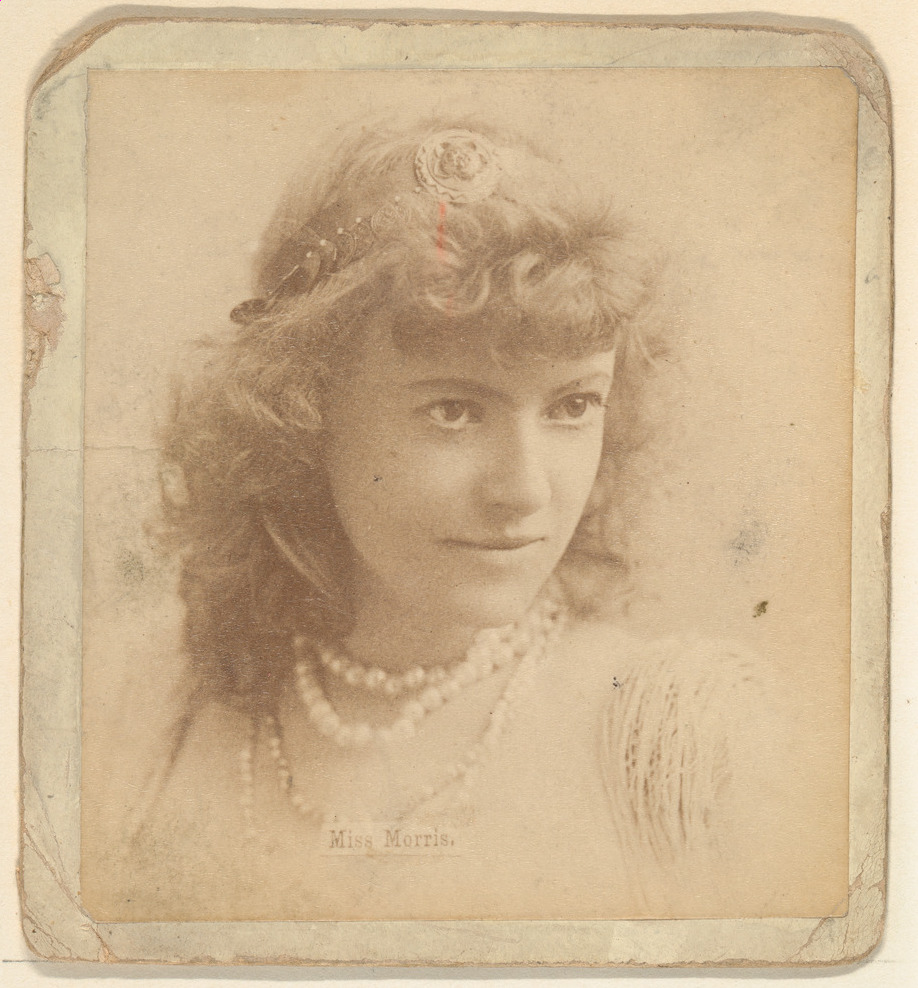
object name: photograph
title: Miss Morris, from the Actresses series (N246), Type 2, issued by Kinney Brothers to promote Sporting Extra Cigarettes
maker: kinney brothers tobacco company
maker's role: publisher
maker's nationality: american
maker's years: 1869-2011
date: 1890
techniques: albumen silver print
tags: portraits,women,actresses